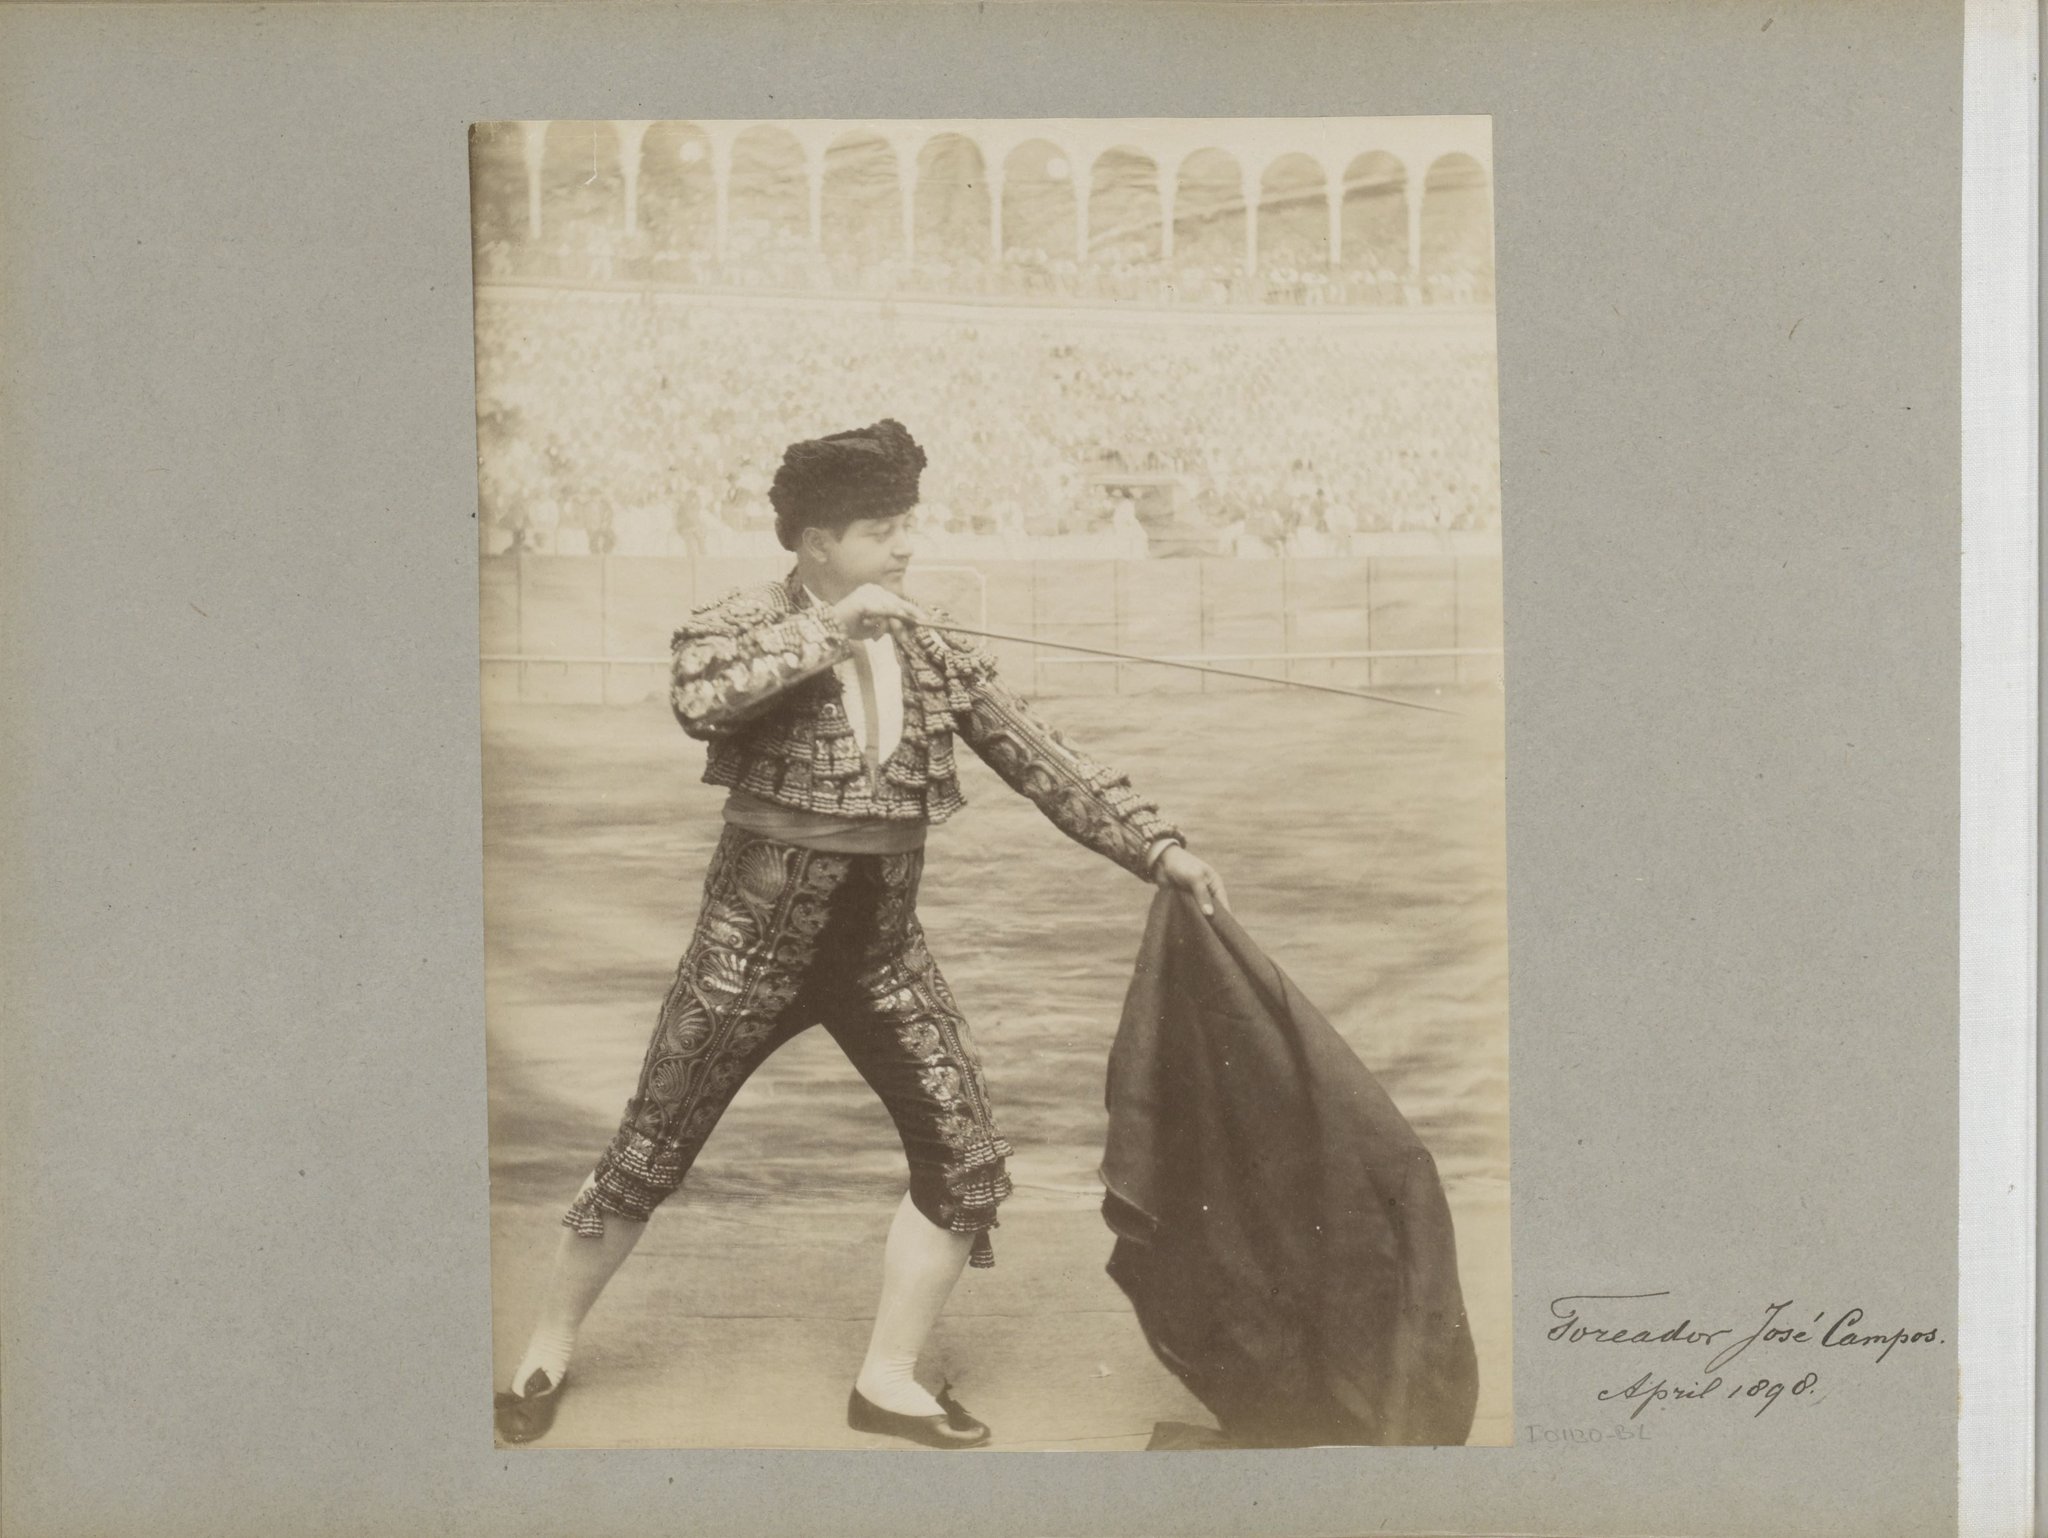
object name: album leaf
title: Portret van torero José Campos, met arena als studiodecor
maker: Anonymous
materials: paper, photographic support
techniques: albumen print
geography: spain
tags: studio requisites ~ photographer, bullfight, bull-fighter, toreador, grounds, fields and accomodations for sports, games and physical performances (+ out of doors (sports, games, etc.)), spain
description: Onderdeel van Reisalbum met foto's van bezienswaardigheden in Frankrijk, Spanje, Italië, Duitsland, Zwitserland en Oostenrijk.